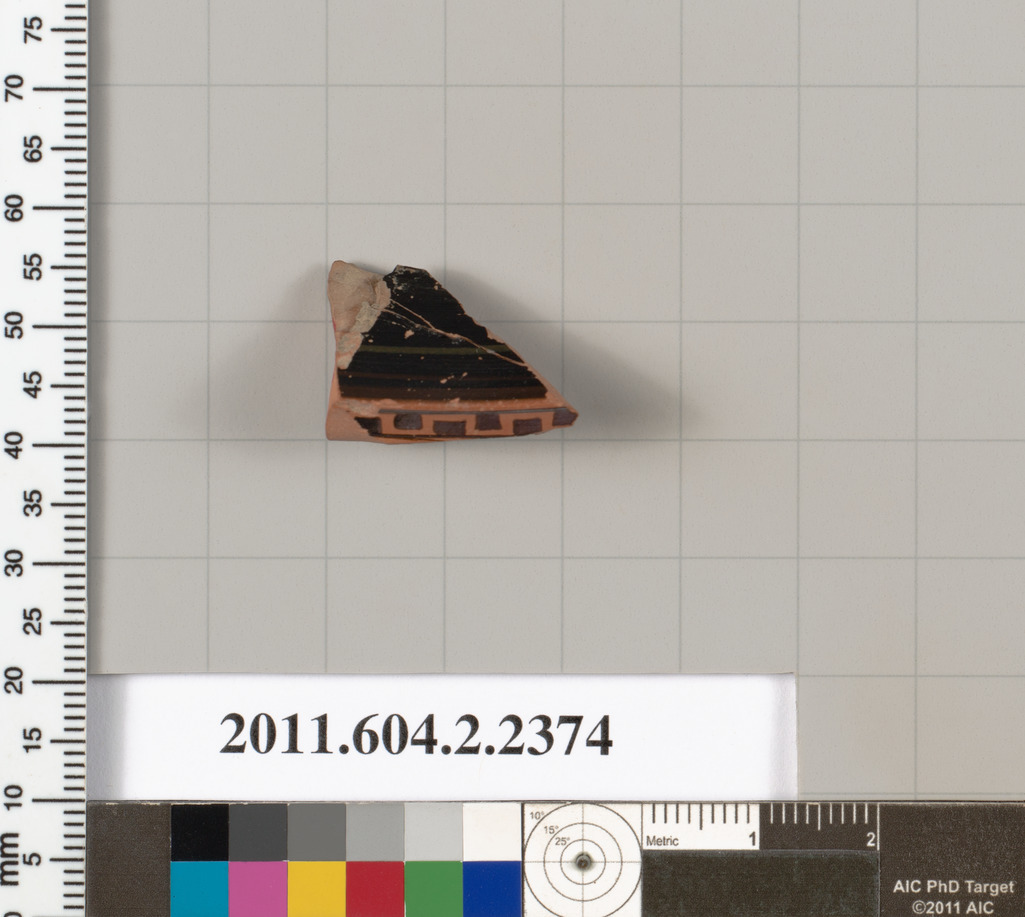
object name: standlet fragment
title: Terracotta fragment of a standlet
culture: greek, attic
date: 534-501 BCE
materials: terracotta